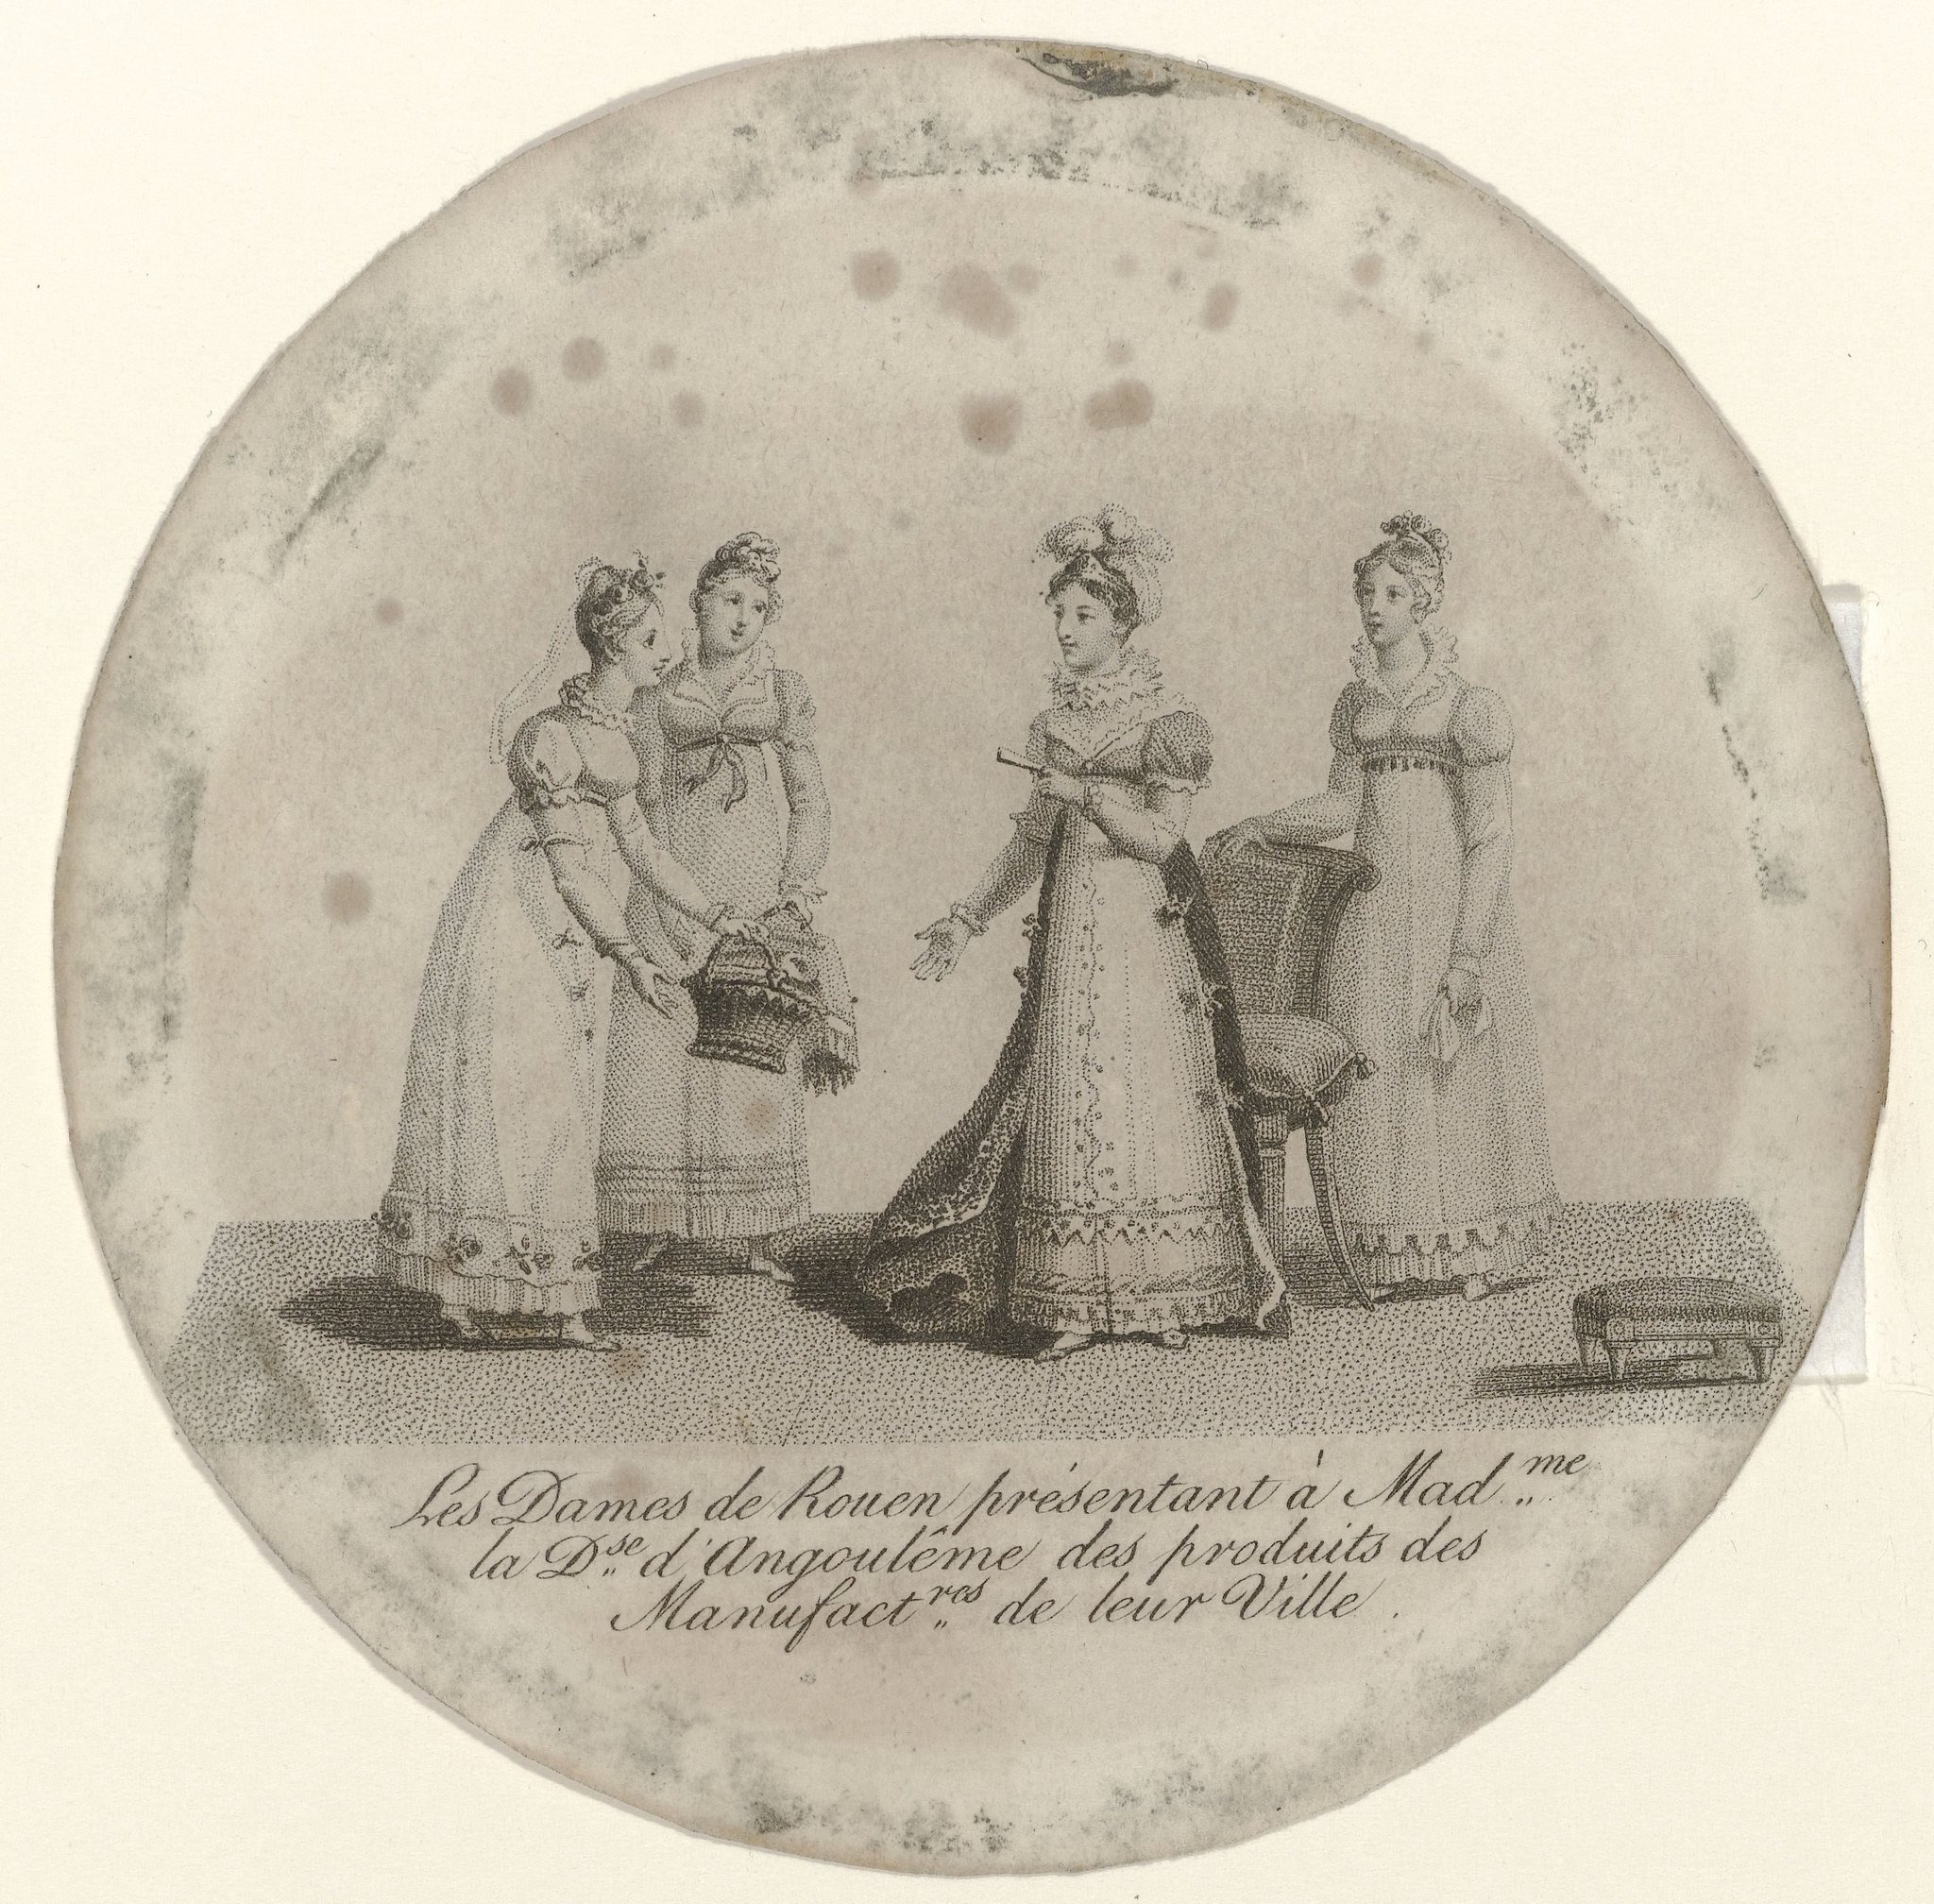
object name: fashion print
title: Les Dames de Rouen, 1800 présentant à Madme la Dse d'Angouleme des produits des Manufact(u)res de leur Ville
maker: Anonymous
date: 1810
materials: paper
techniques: engraving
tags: fashion plates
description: Les Dames de Rouen présentant à Madme la Dse d'Angouleme des produits des Manufact(u)res de leur Ville